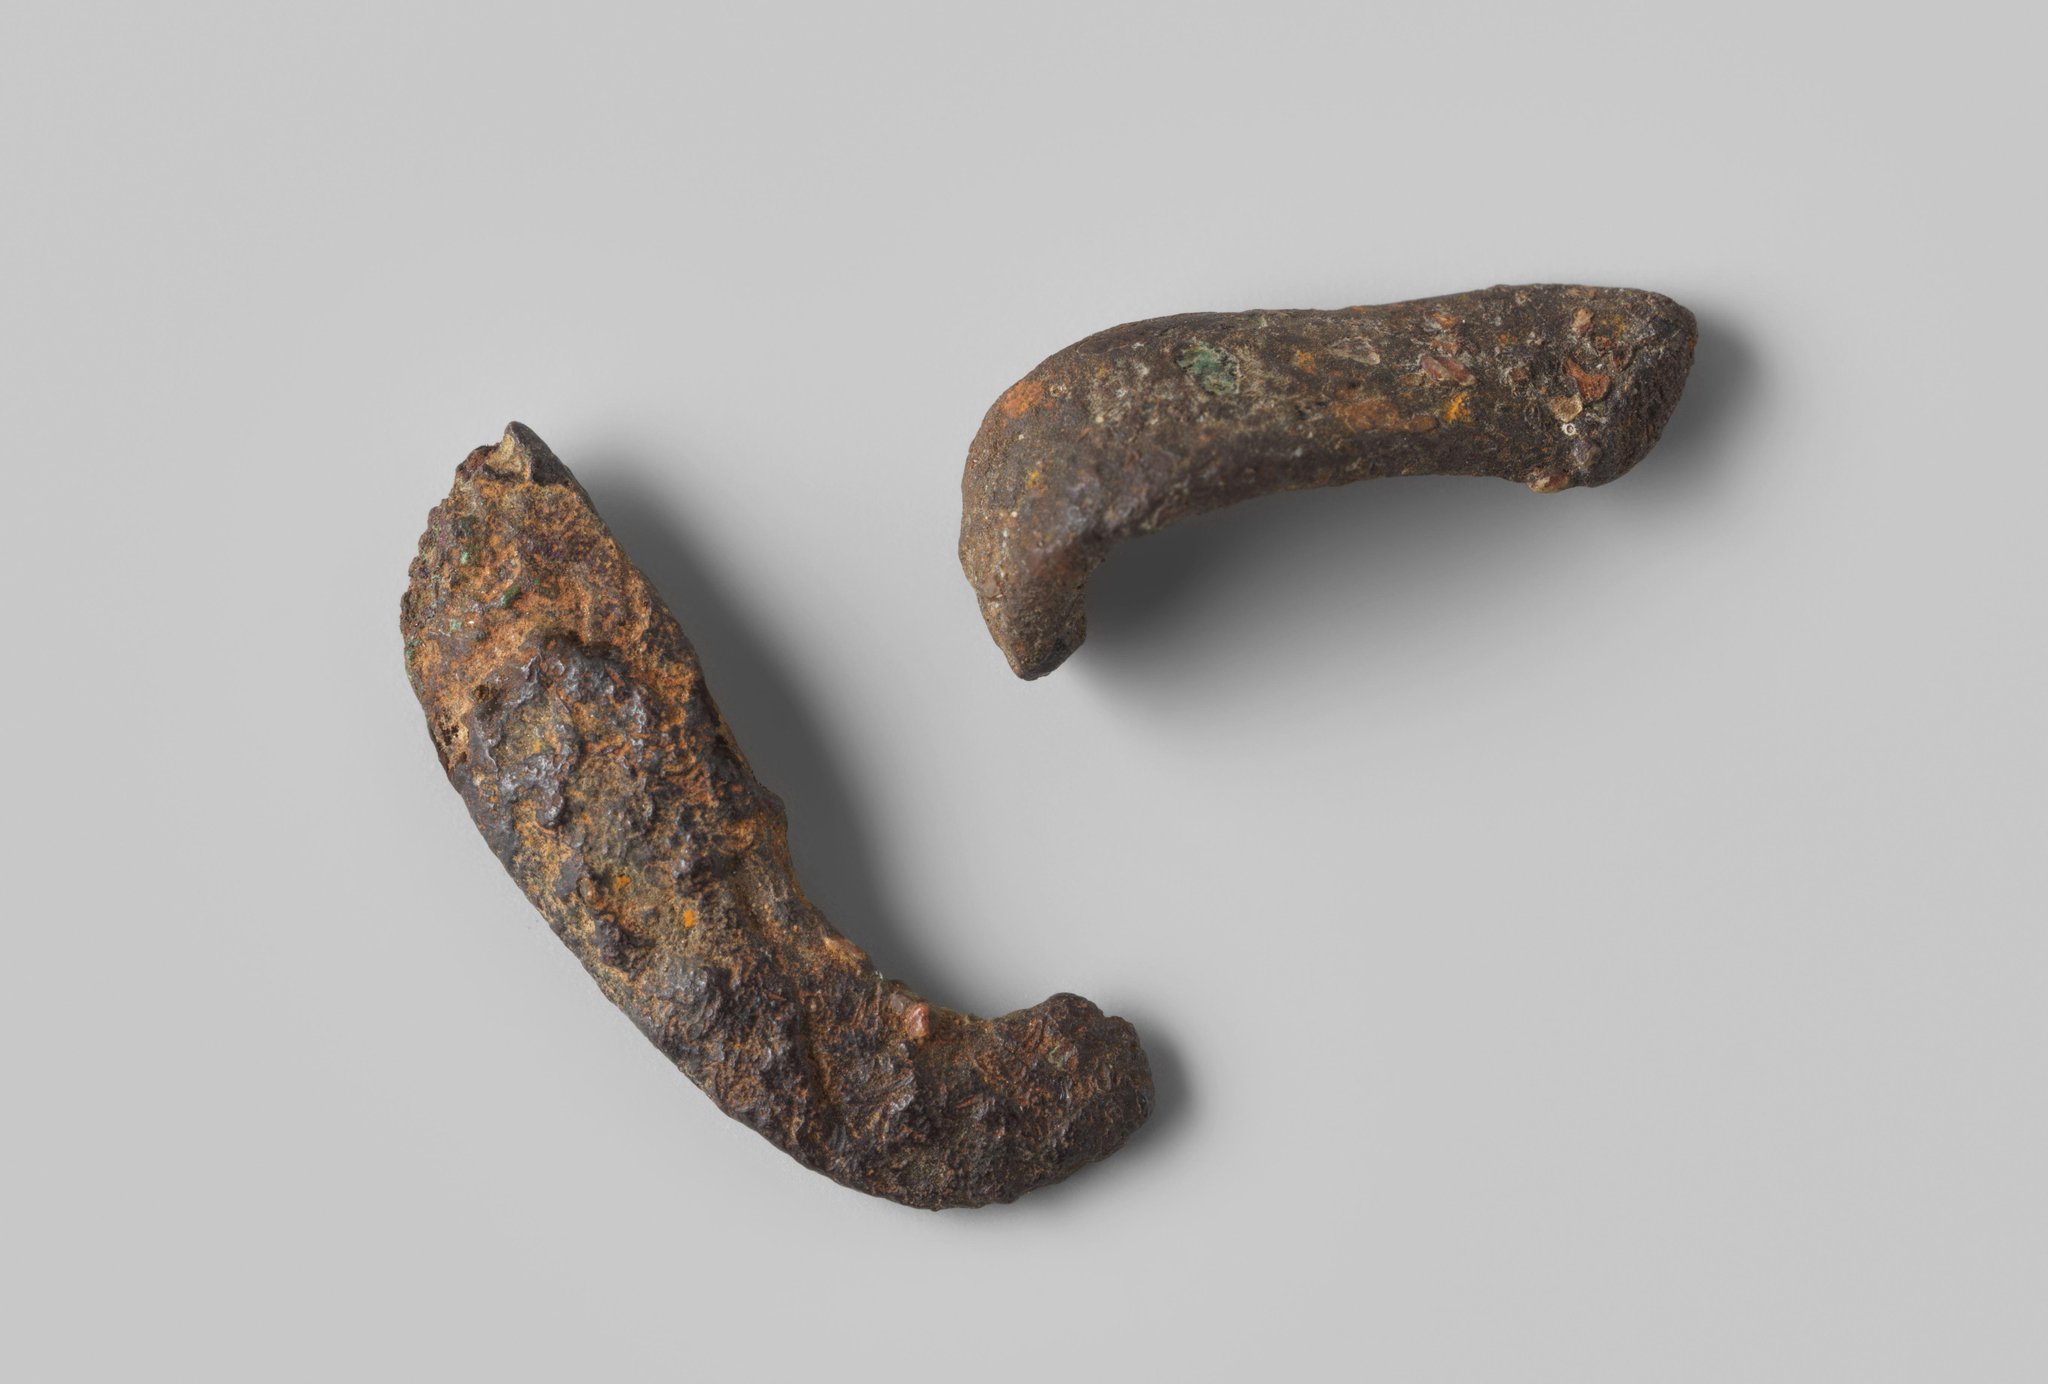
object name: buckle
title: Fragmenten van een gesp uit het wrak van de Oost-Indiëvaarder Hollandia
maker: Anonymous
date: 1700-1743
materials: copper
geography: netherlands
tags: verenigde oostindische compagnie, hollandia (schip), annet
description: Buckle, not identifiable; fragm of ring, eroded, flat, rounded corner.